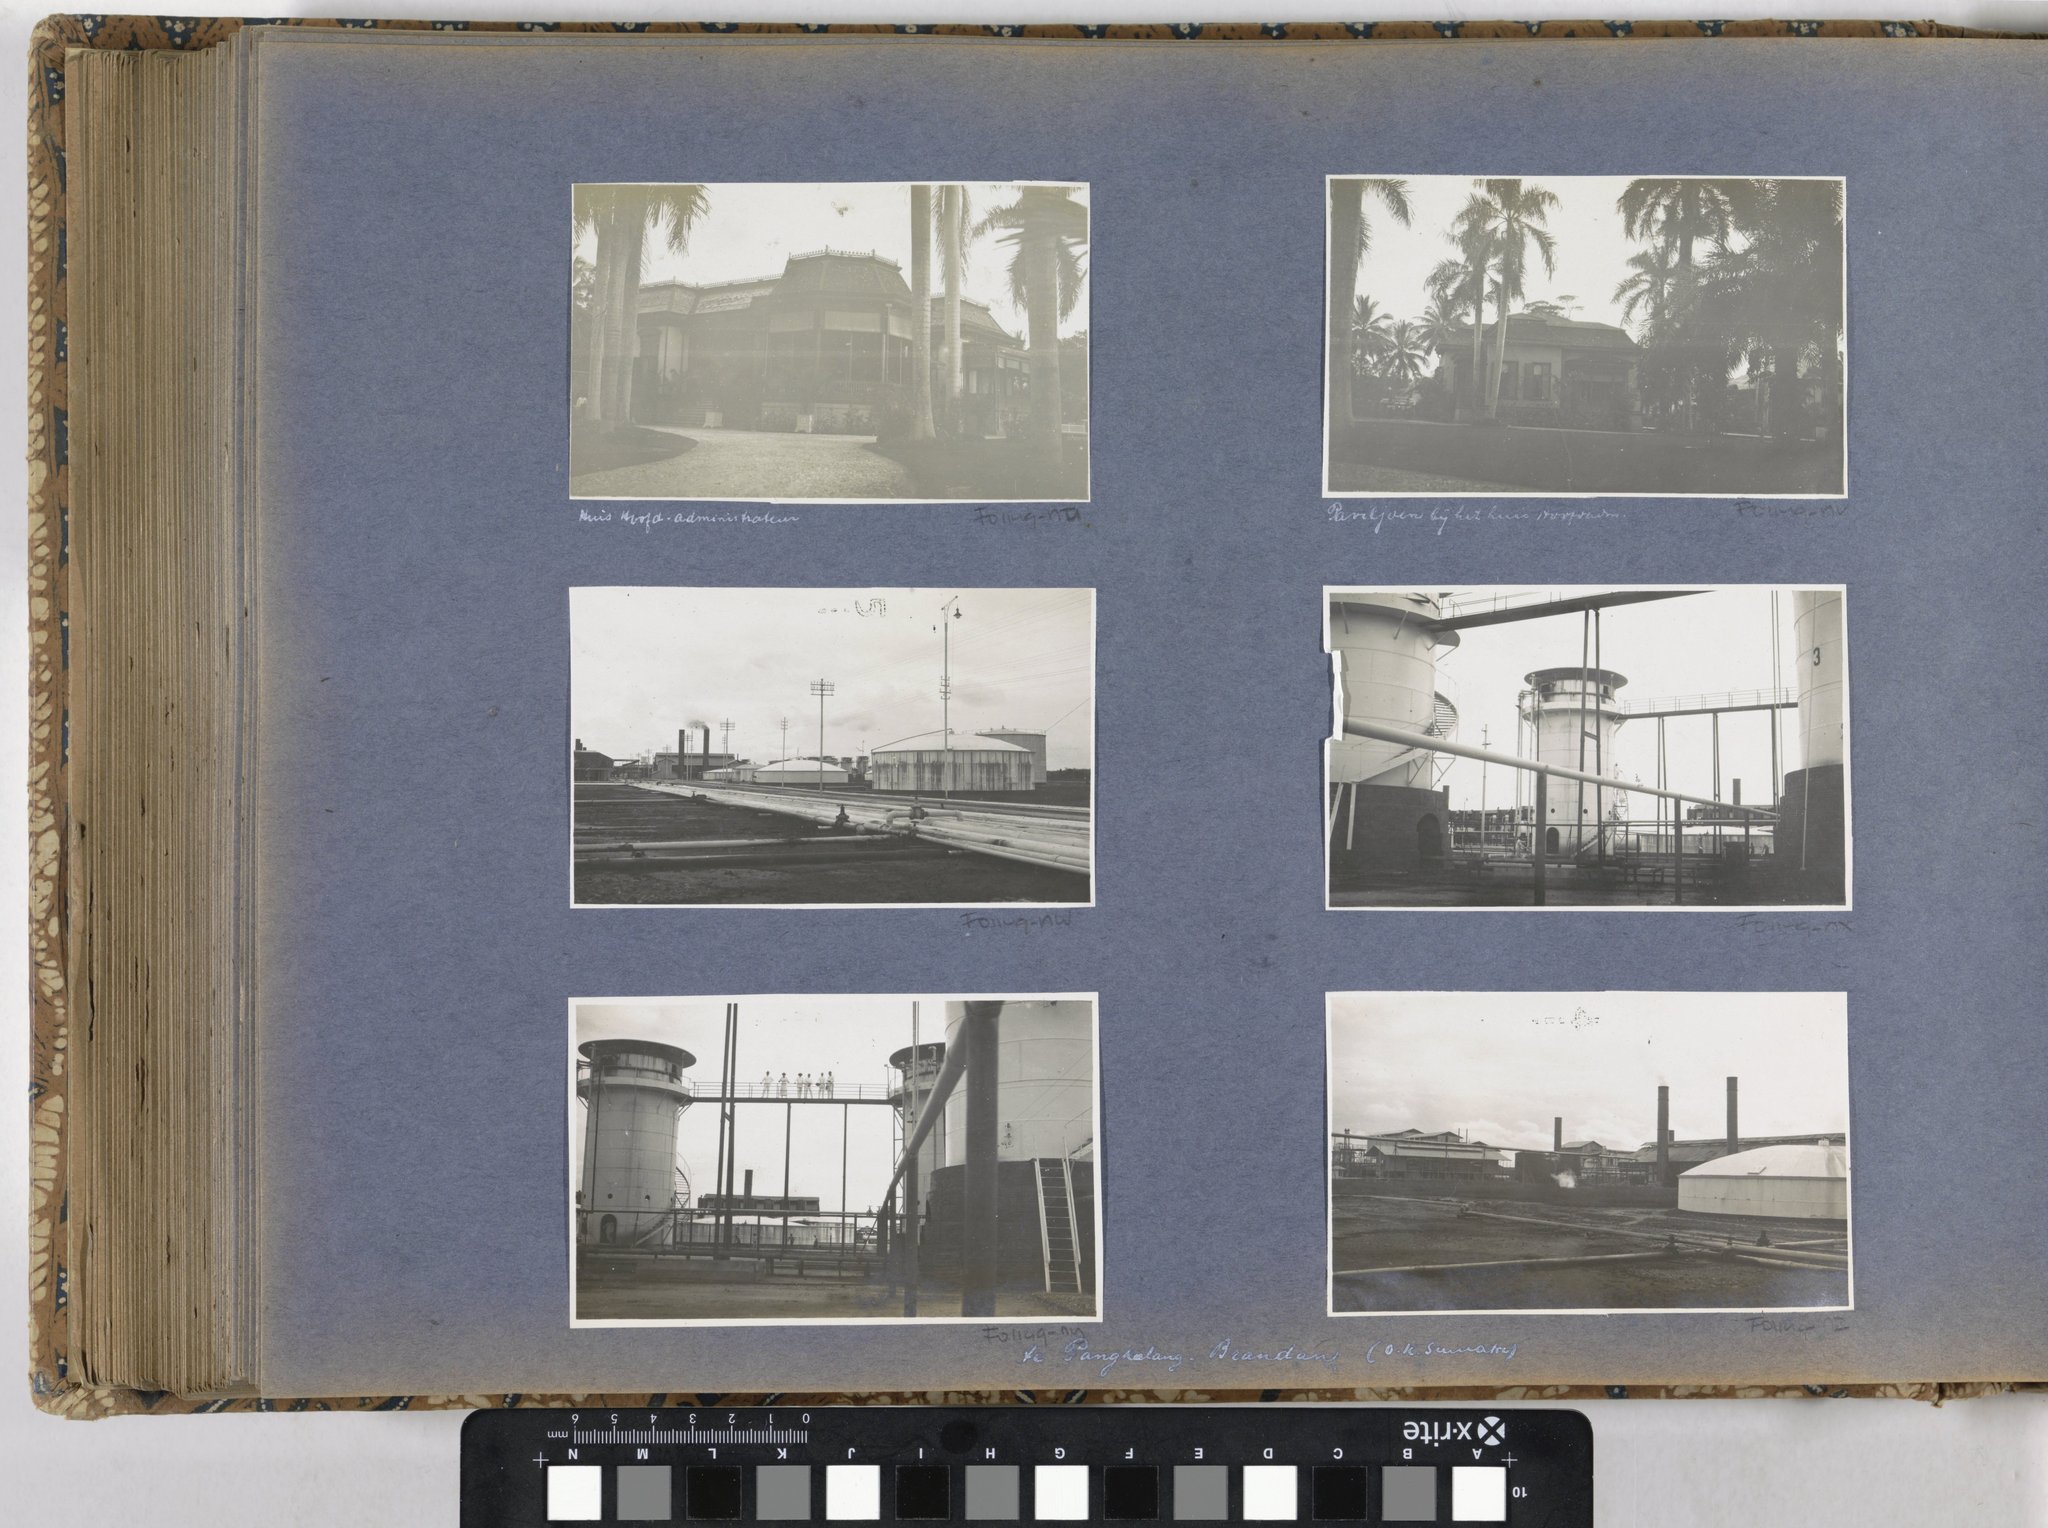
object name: album leaf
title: Fabriekscomplex voor oliewinning te Pangkalan-Brandan op Sumatra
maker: Anonymous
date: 1900-1920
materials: paper, photographic support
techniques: gelatin silver print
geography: sumatra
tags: smoke-stack, oil tanks, oil; oil refinery, sumatra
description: Onderdeel van reisalbum met foto's van bedrijvigheid en bezienswaardigheden op Sumatra en Java en van de reis naar en van Nederlands-Indië.